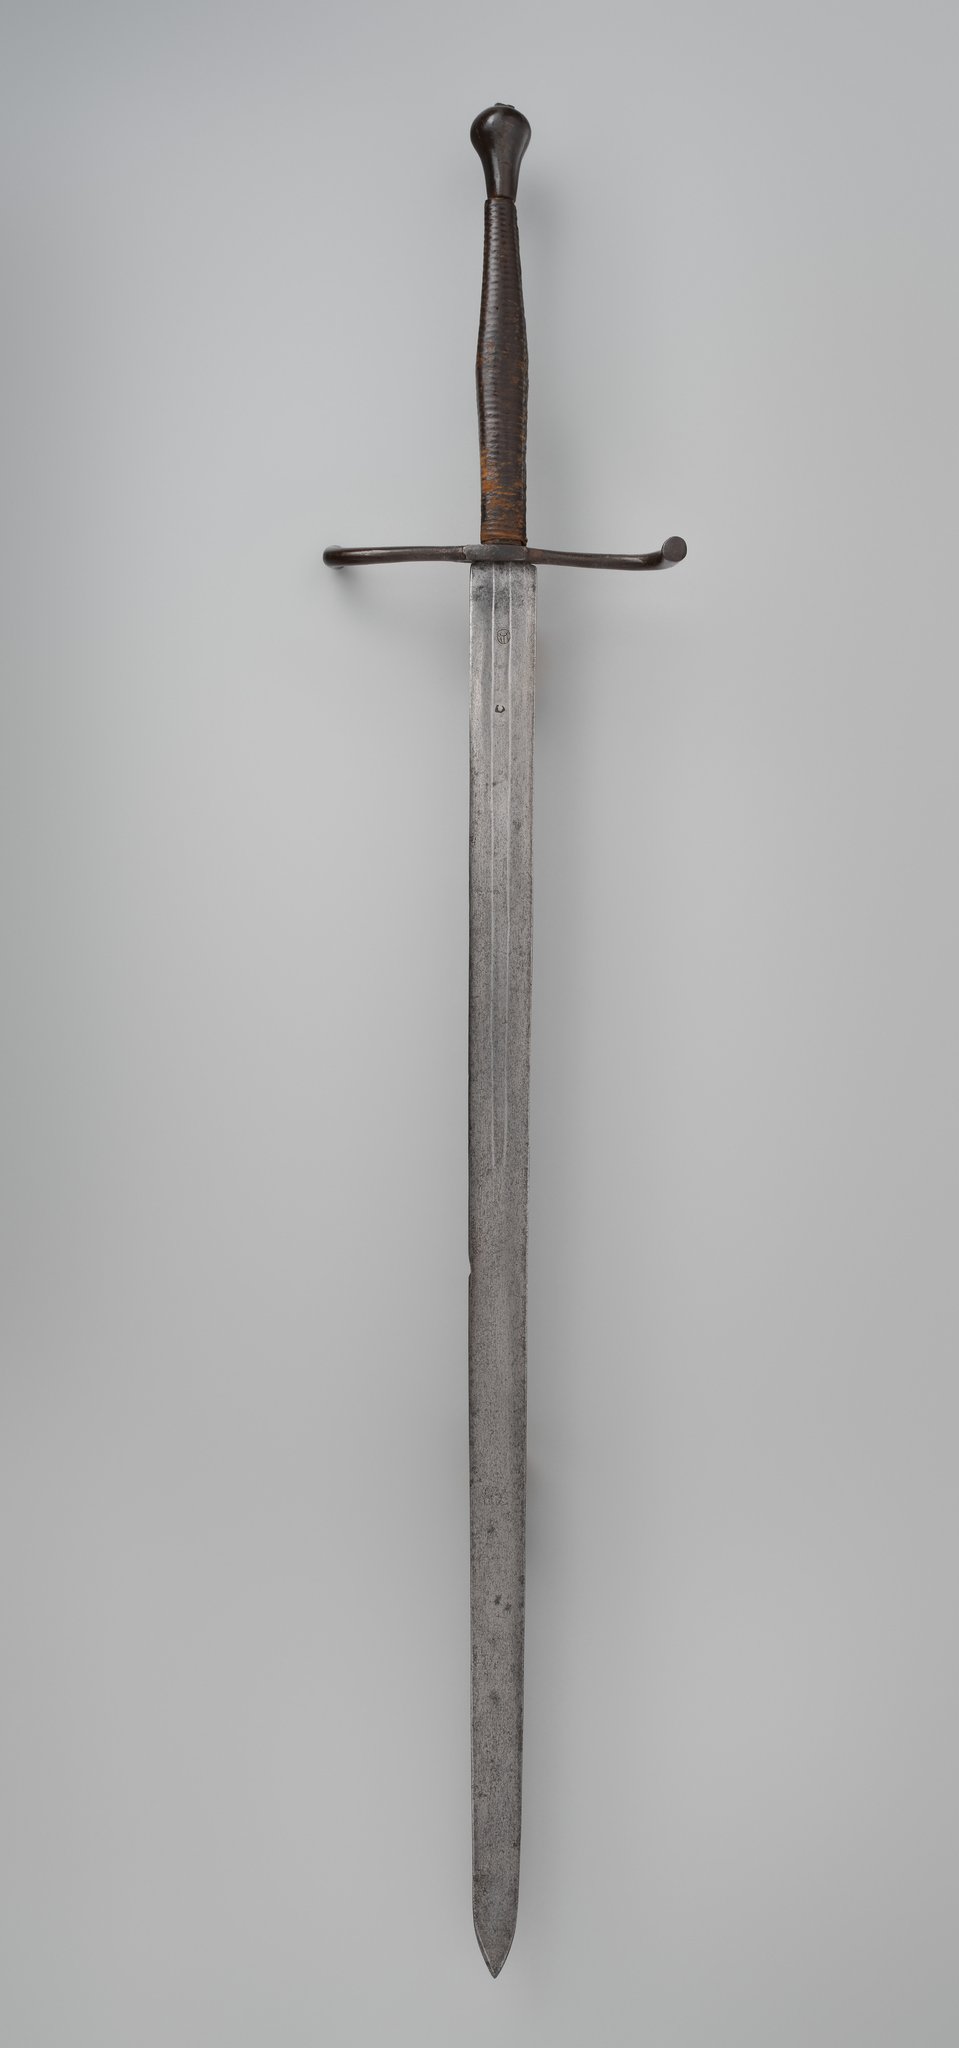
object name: hand and a half sword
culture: german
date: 1500-1525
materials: leather, steel, wood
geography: germany